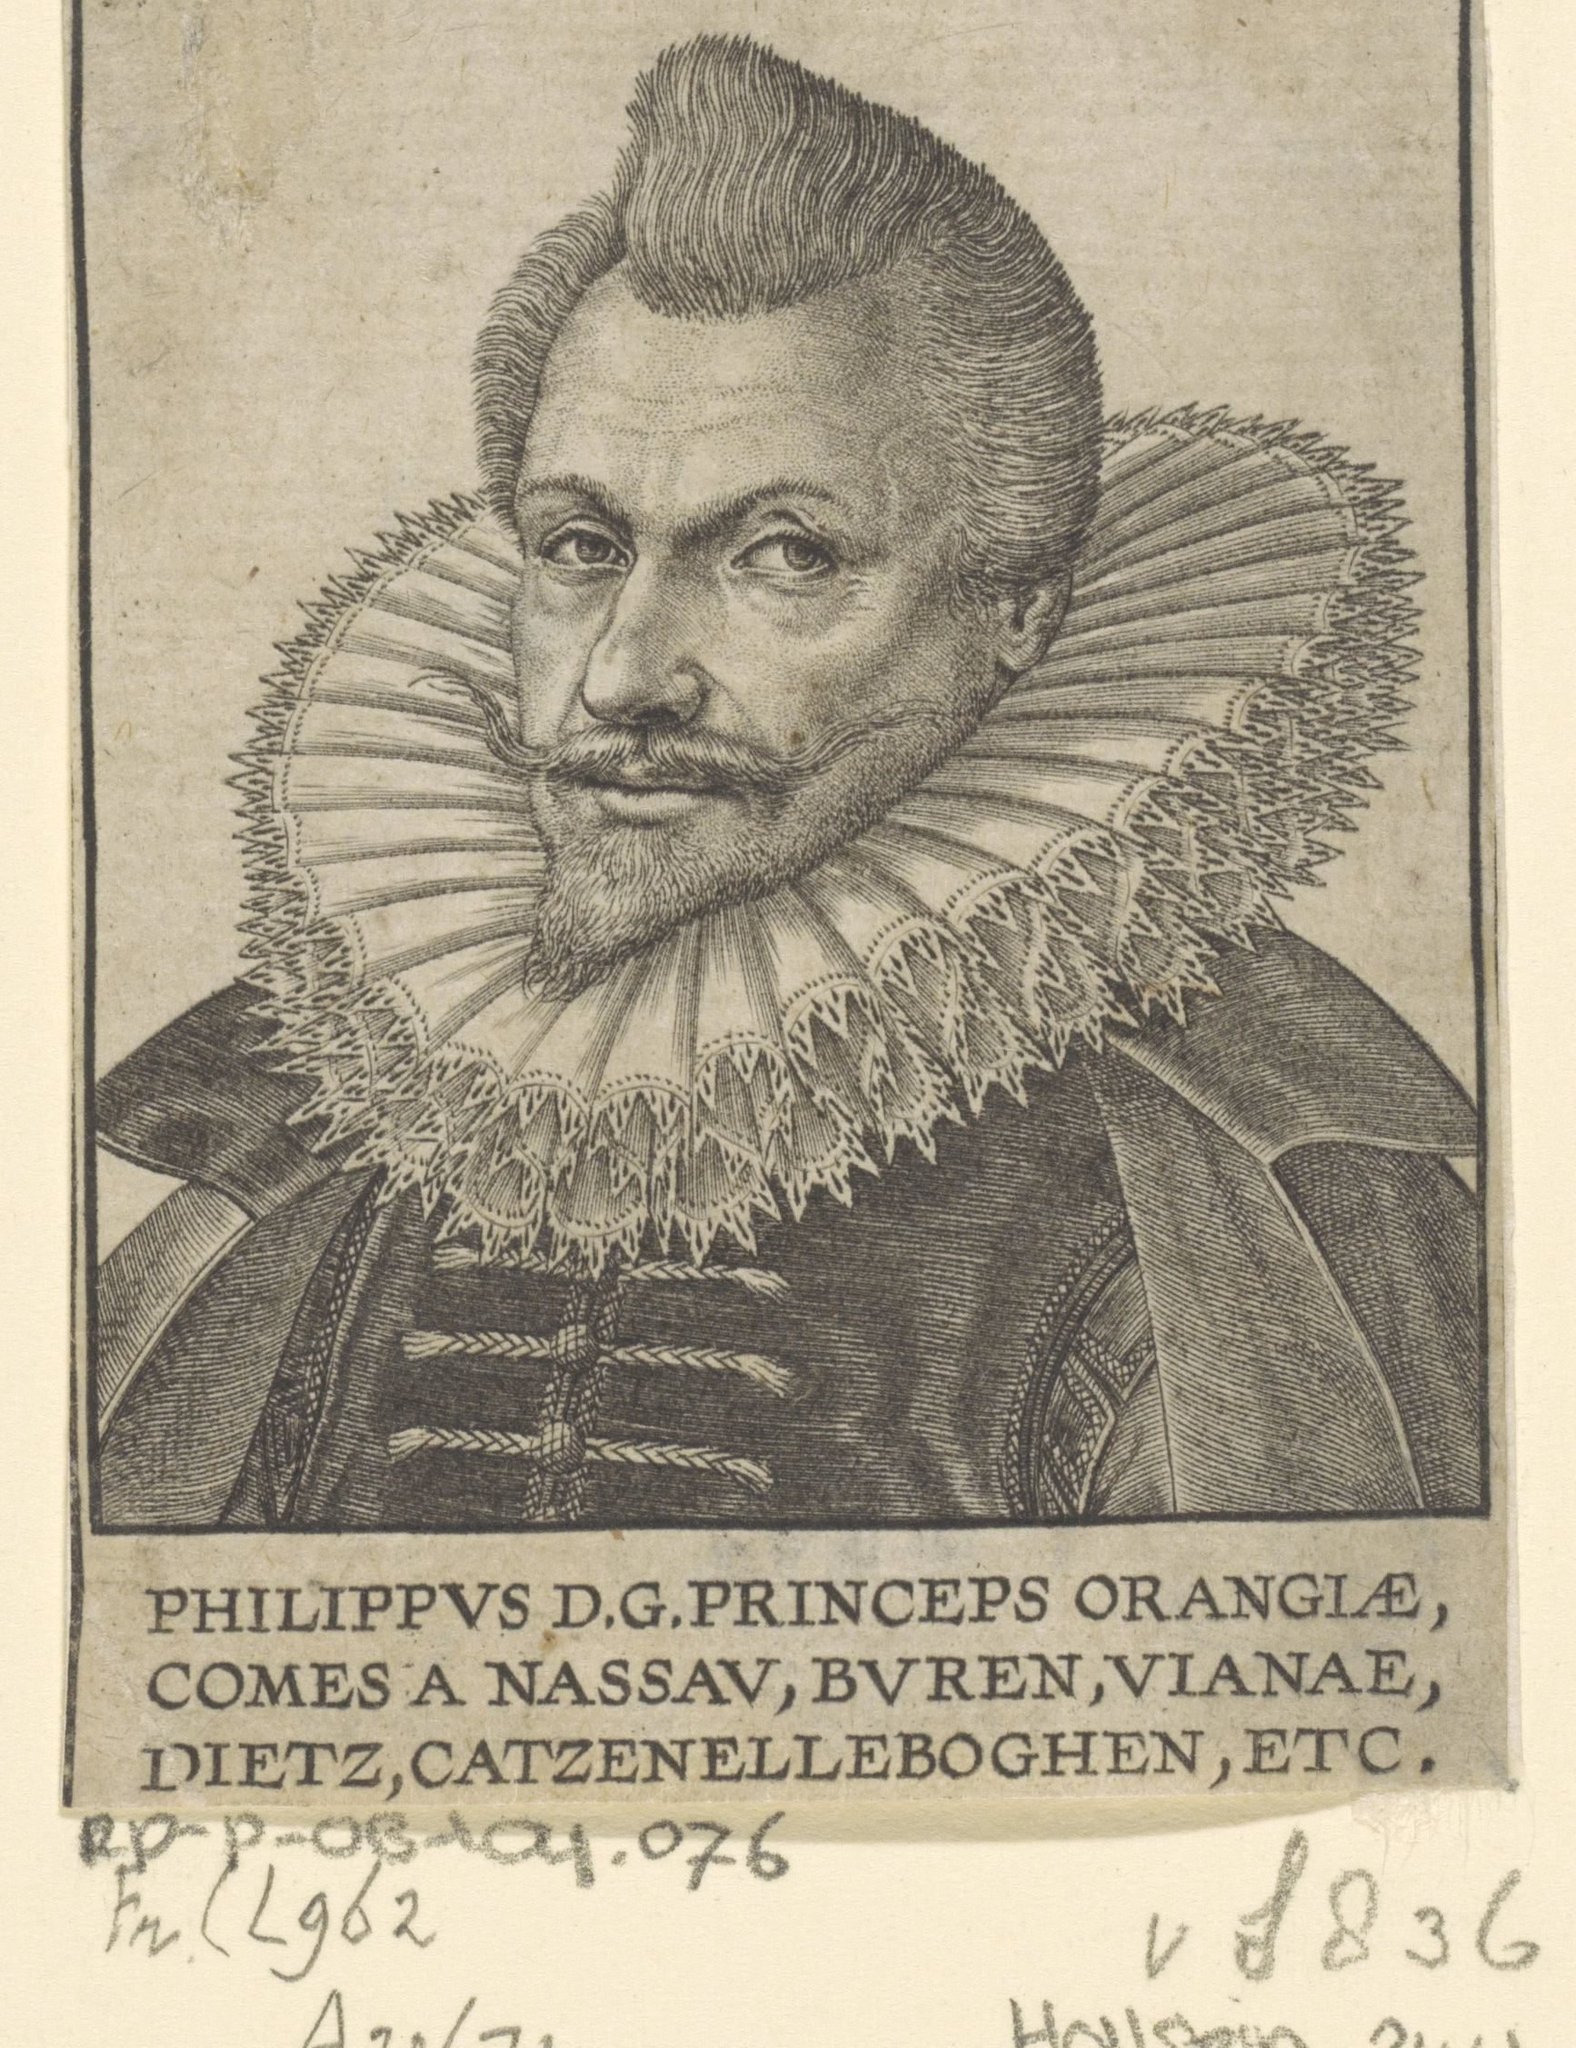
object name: print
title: Portret van Filips Willem, prins van Oranje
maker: antonie wierix (ii)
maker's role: draughtsman, print maker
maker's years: 1555-1604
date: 1604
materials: paper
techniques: engraving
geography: antwerp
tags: buren, bruges, filips willem (prins van oranje)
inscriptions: collector's mark: Lugt 963, collector's mark: Lugt 2228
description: De hier vermelde titel verwijst naar de hoogst verkregen titel van de geportretteerde, niet per se naar de titel die de geportretteerde op deze voorstelling draagt.